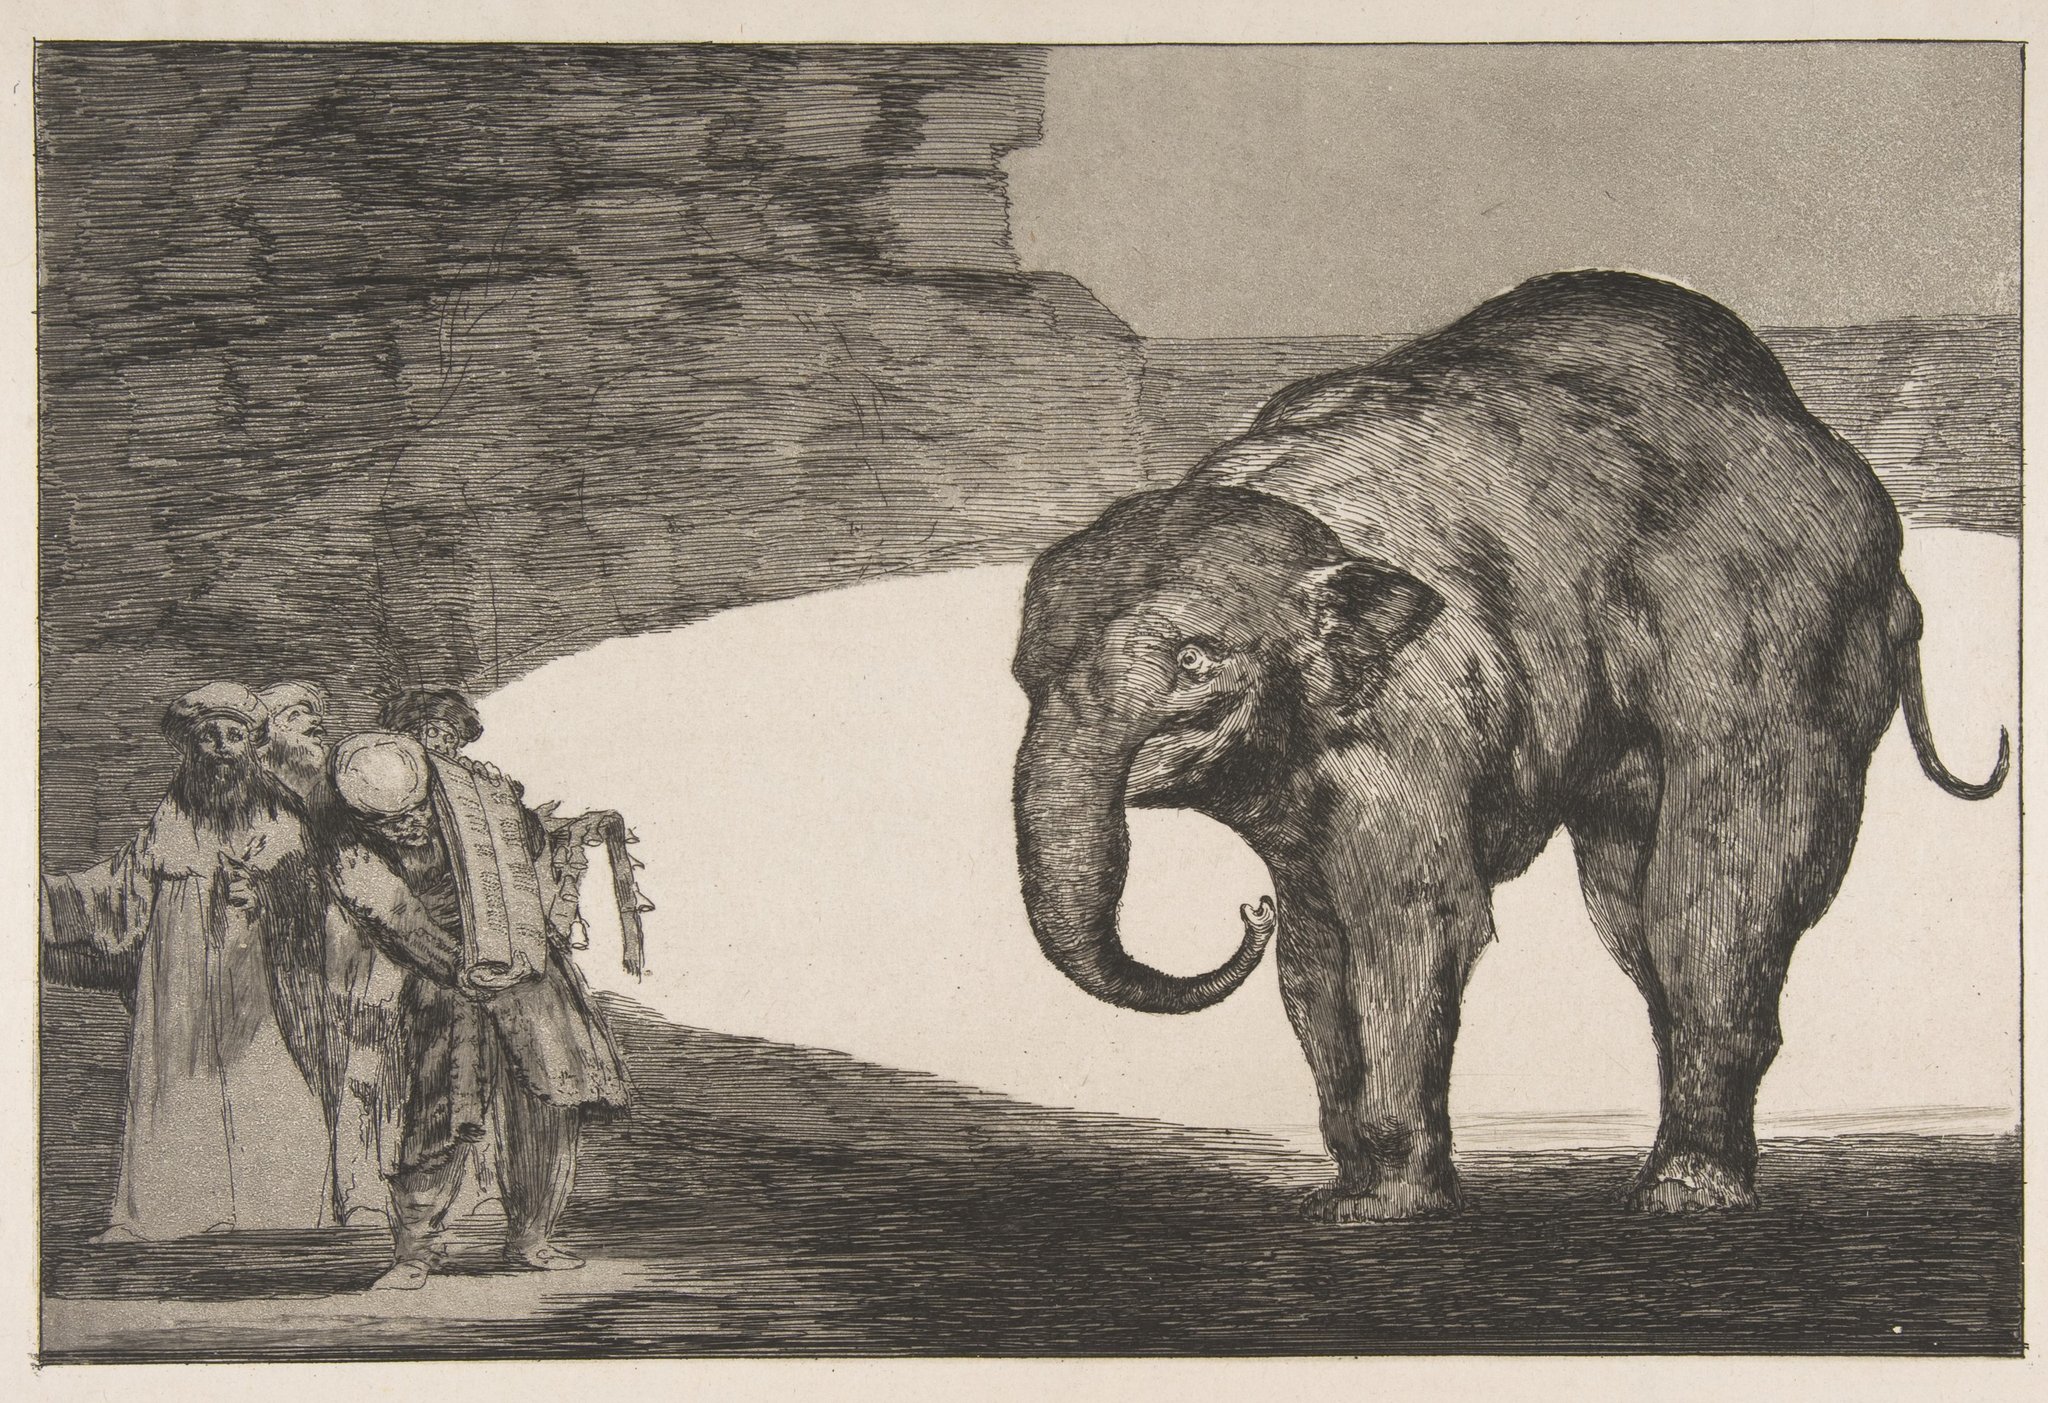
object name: print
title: 'Animal Folly' from the 'Disparates' (Follies / Irrationalities)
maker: goya (francisco de goya y lucientes)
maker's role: artist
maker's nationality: spanish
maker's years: 1746-1828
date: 1815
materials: paper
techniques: aquatint, drypoint, etching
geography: spain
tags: men,elephants